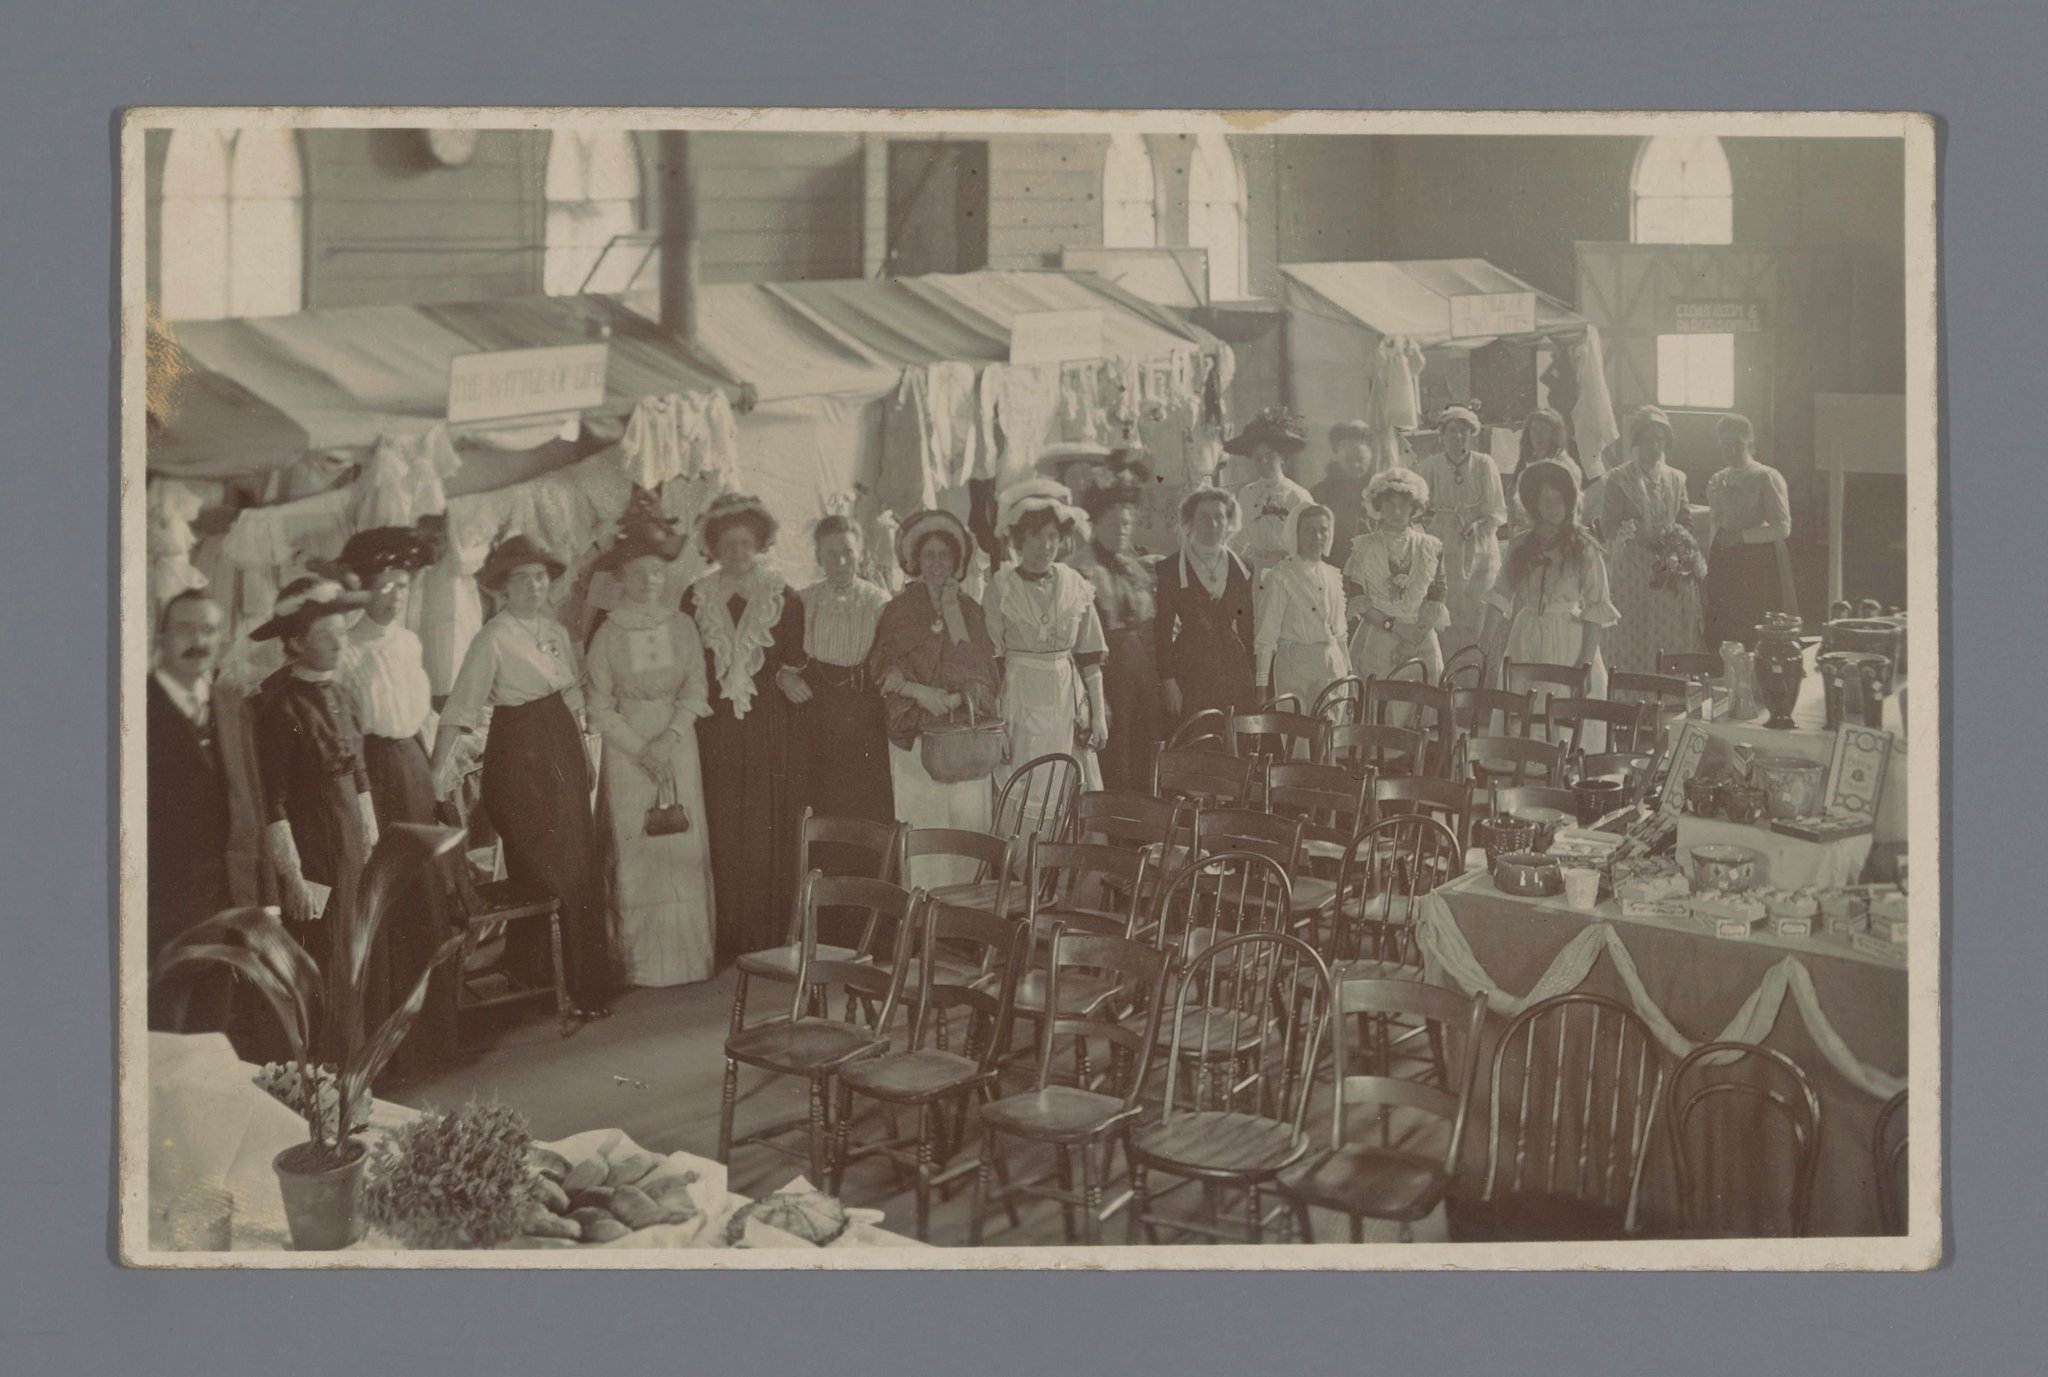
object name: ansichtkaart, prentbriefkaart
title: Groepsportret van onbekende vrouwen in een evenementenhal, mogelijk leden van een liefdadigheidsvereniging tijdens een liefdadigheidsevenement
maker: Anonymous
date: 1920-1930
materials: photographic support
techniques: gelatin silver print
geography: great britain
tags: interior ~ representation of a building, charitable works, anonymous historical persons portrayed in a group, in a group-portrait